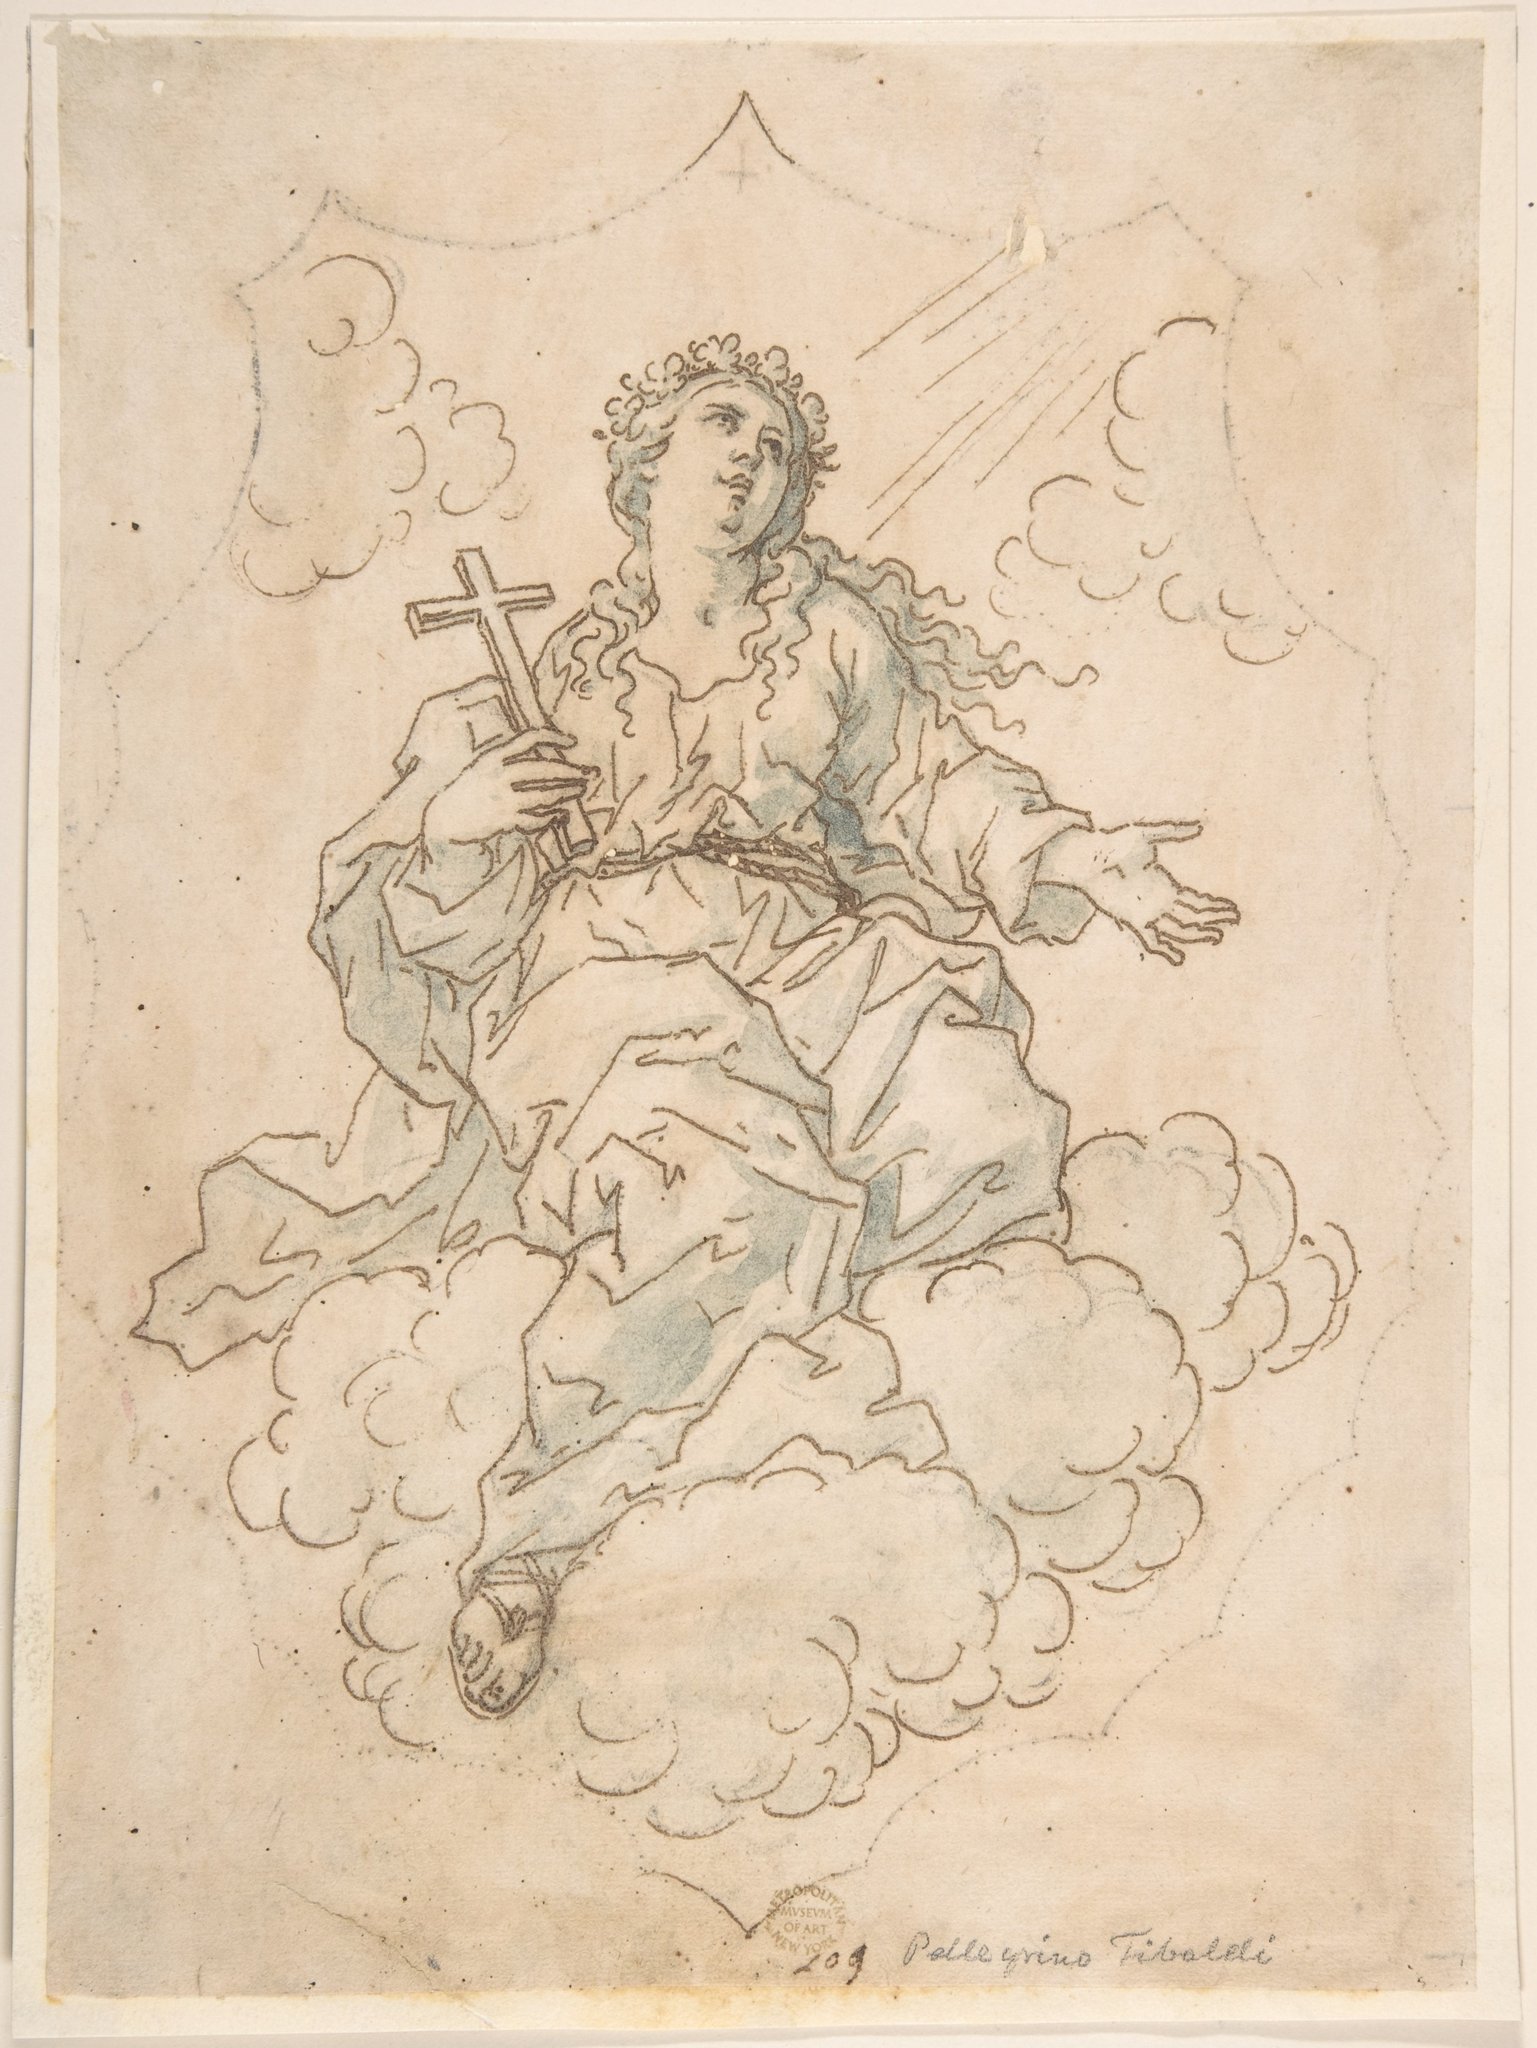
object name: drawing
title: Assumption of Mary Magdalen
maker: anonymous, italian, roman-bolognese, 17th century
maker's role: artist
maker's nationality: italian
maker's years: 1600-1700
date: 1601-1700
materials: chalk, ink, paper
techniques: brush, pen, wash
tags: cross,assumption of the virgin